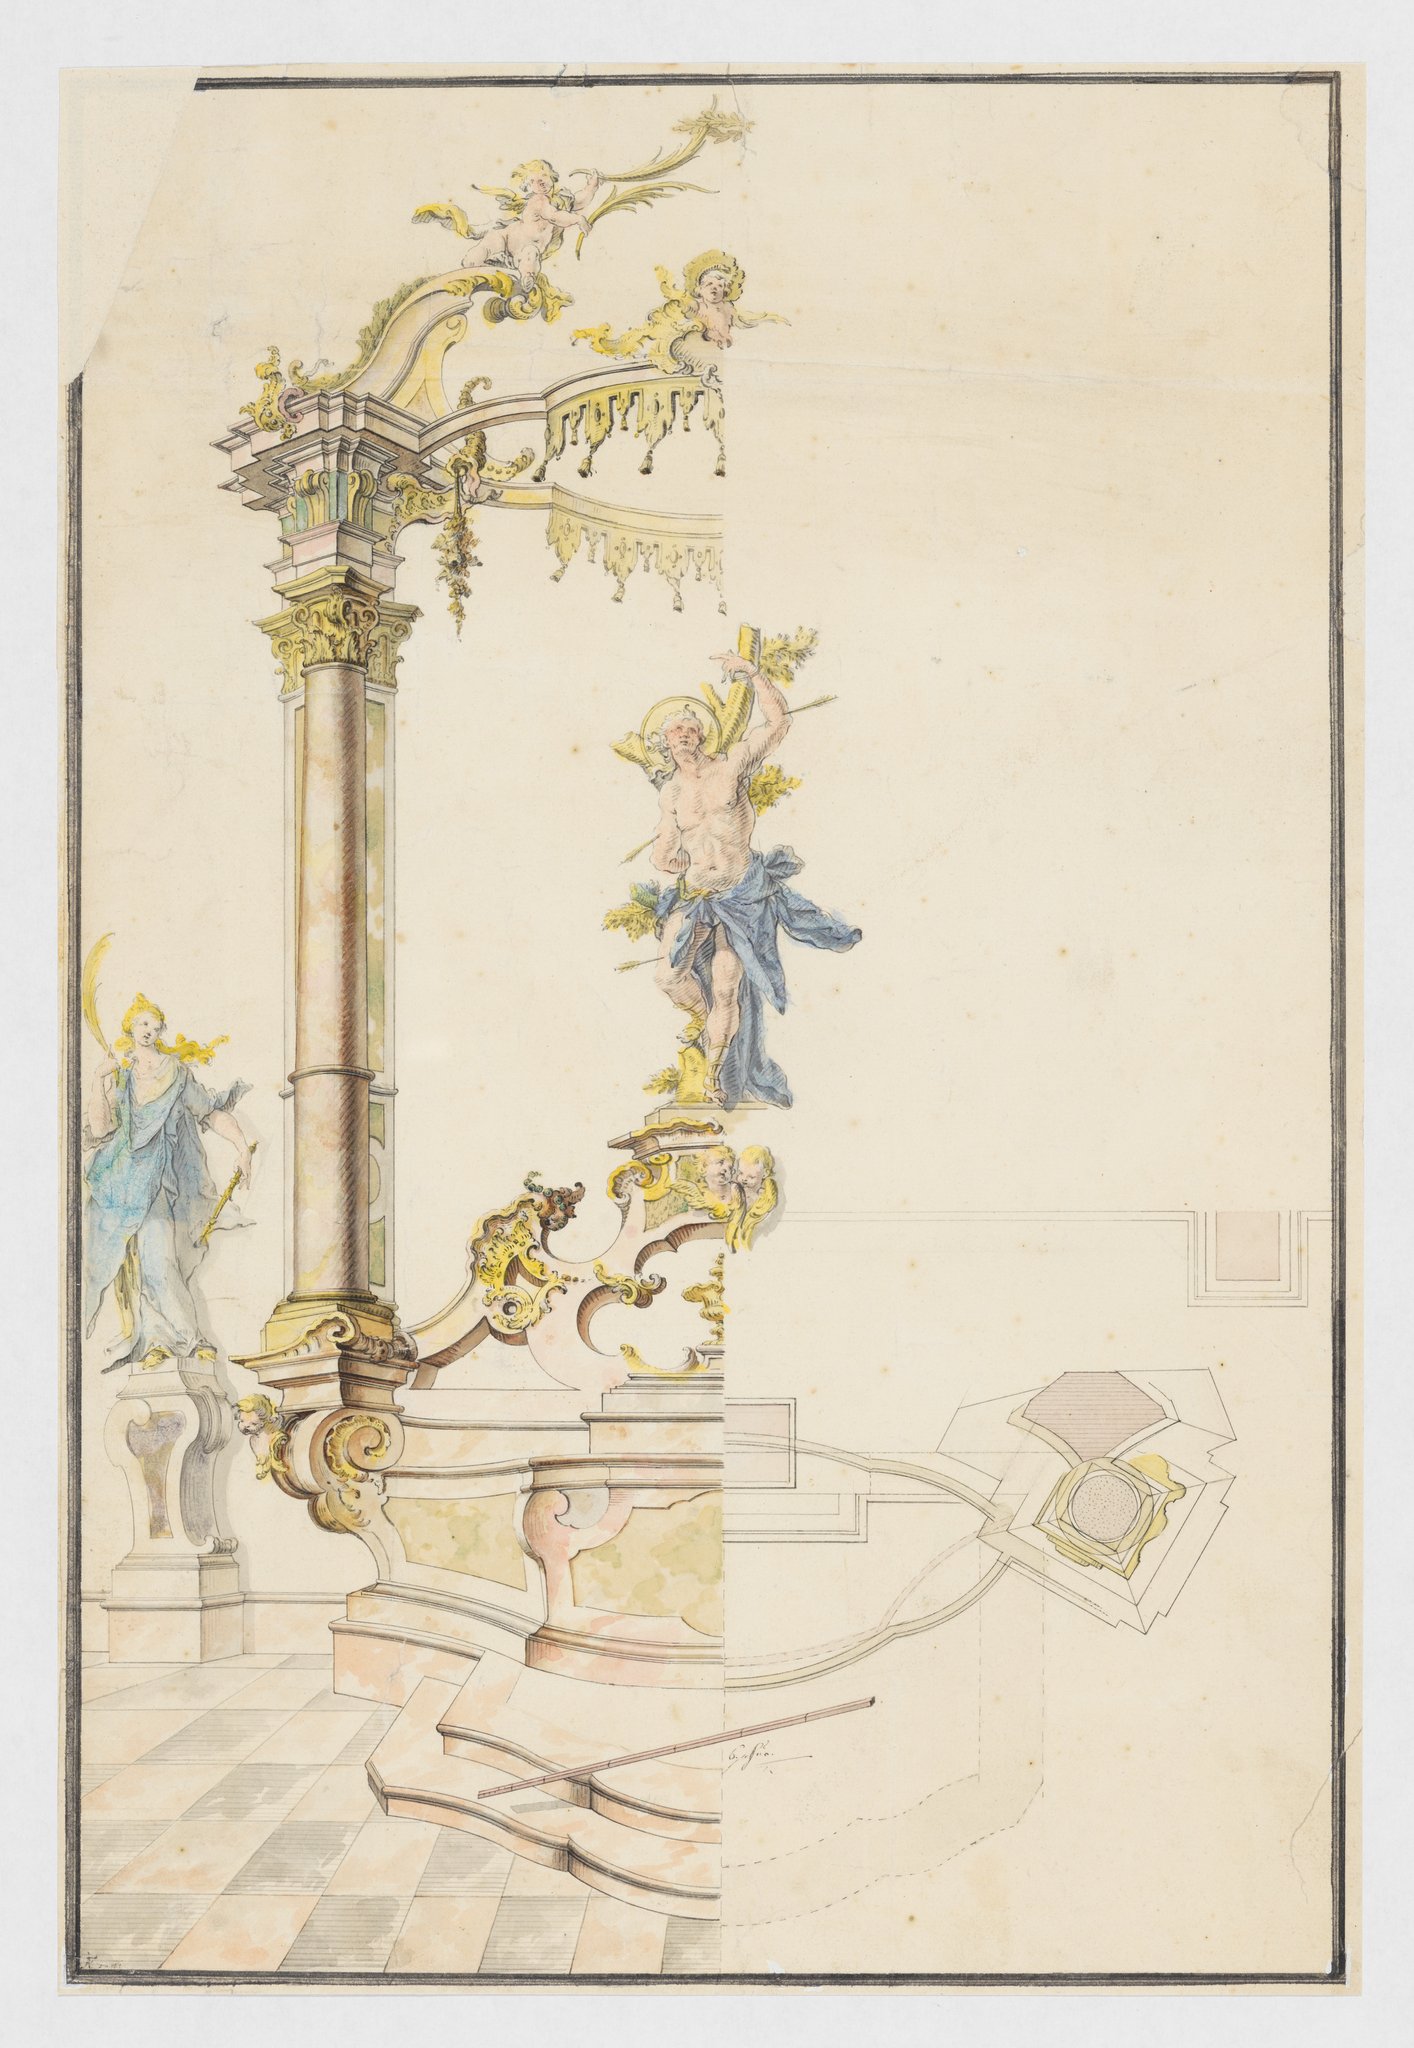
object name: ornament architecture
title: Design for an Altarpiece with a Figure of St. Sebastian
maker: joseph anton feuchtmayer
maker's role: artist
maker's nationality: german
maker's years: 1696-1770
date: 1741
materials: ink, watercolor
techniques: pen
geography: germany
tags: altars,saint sebastian